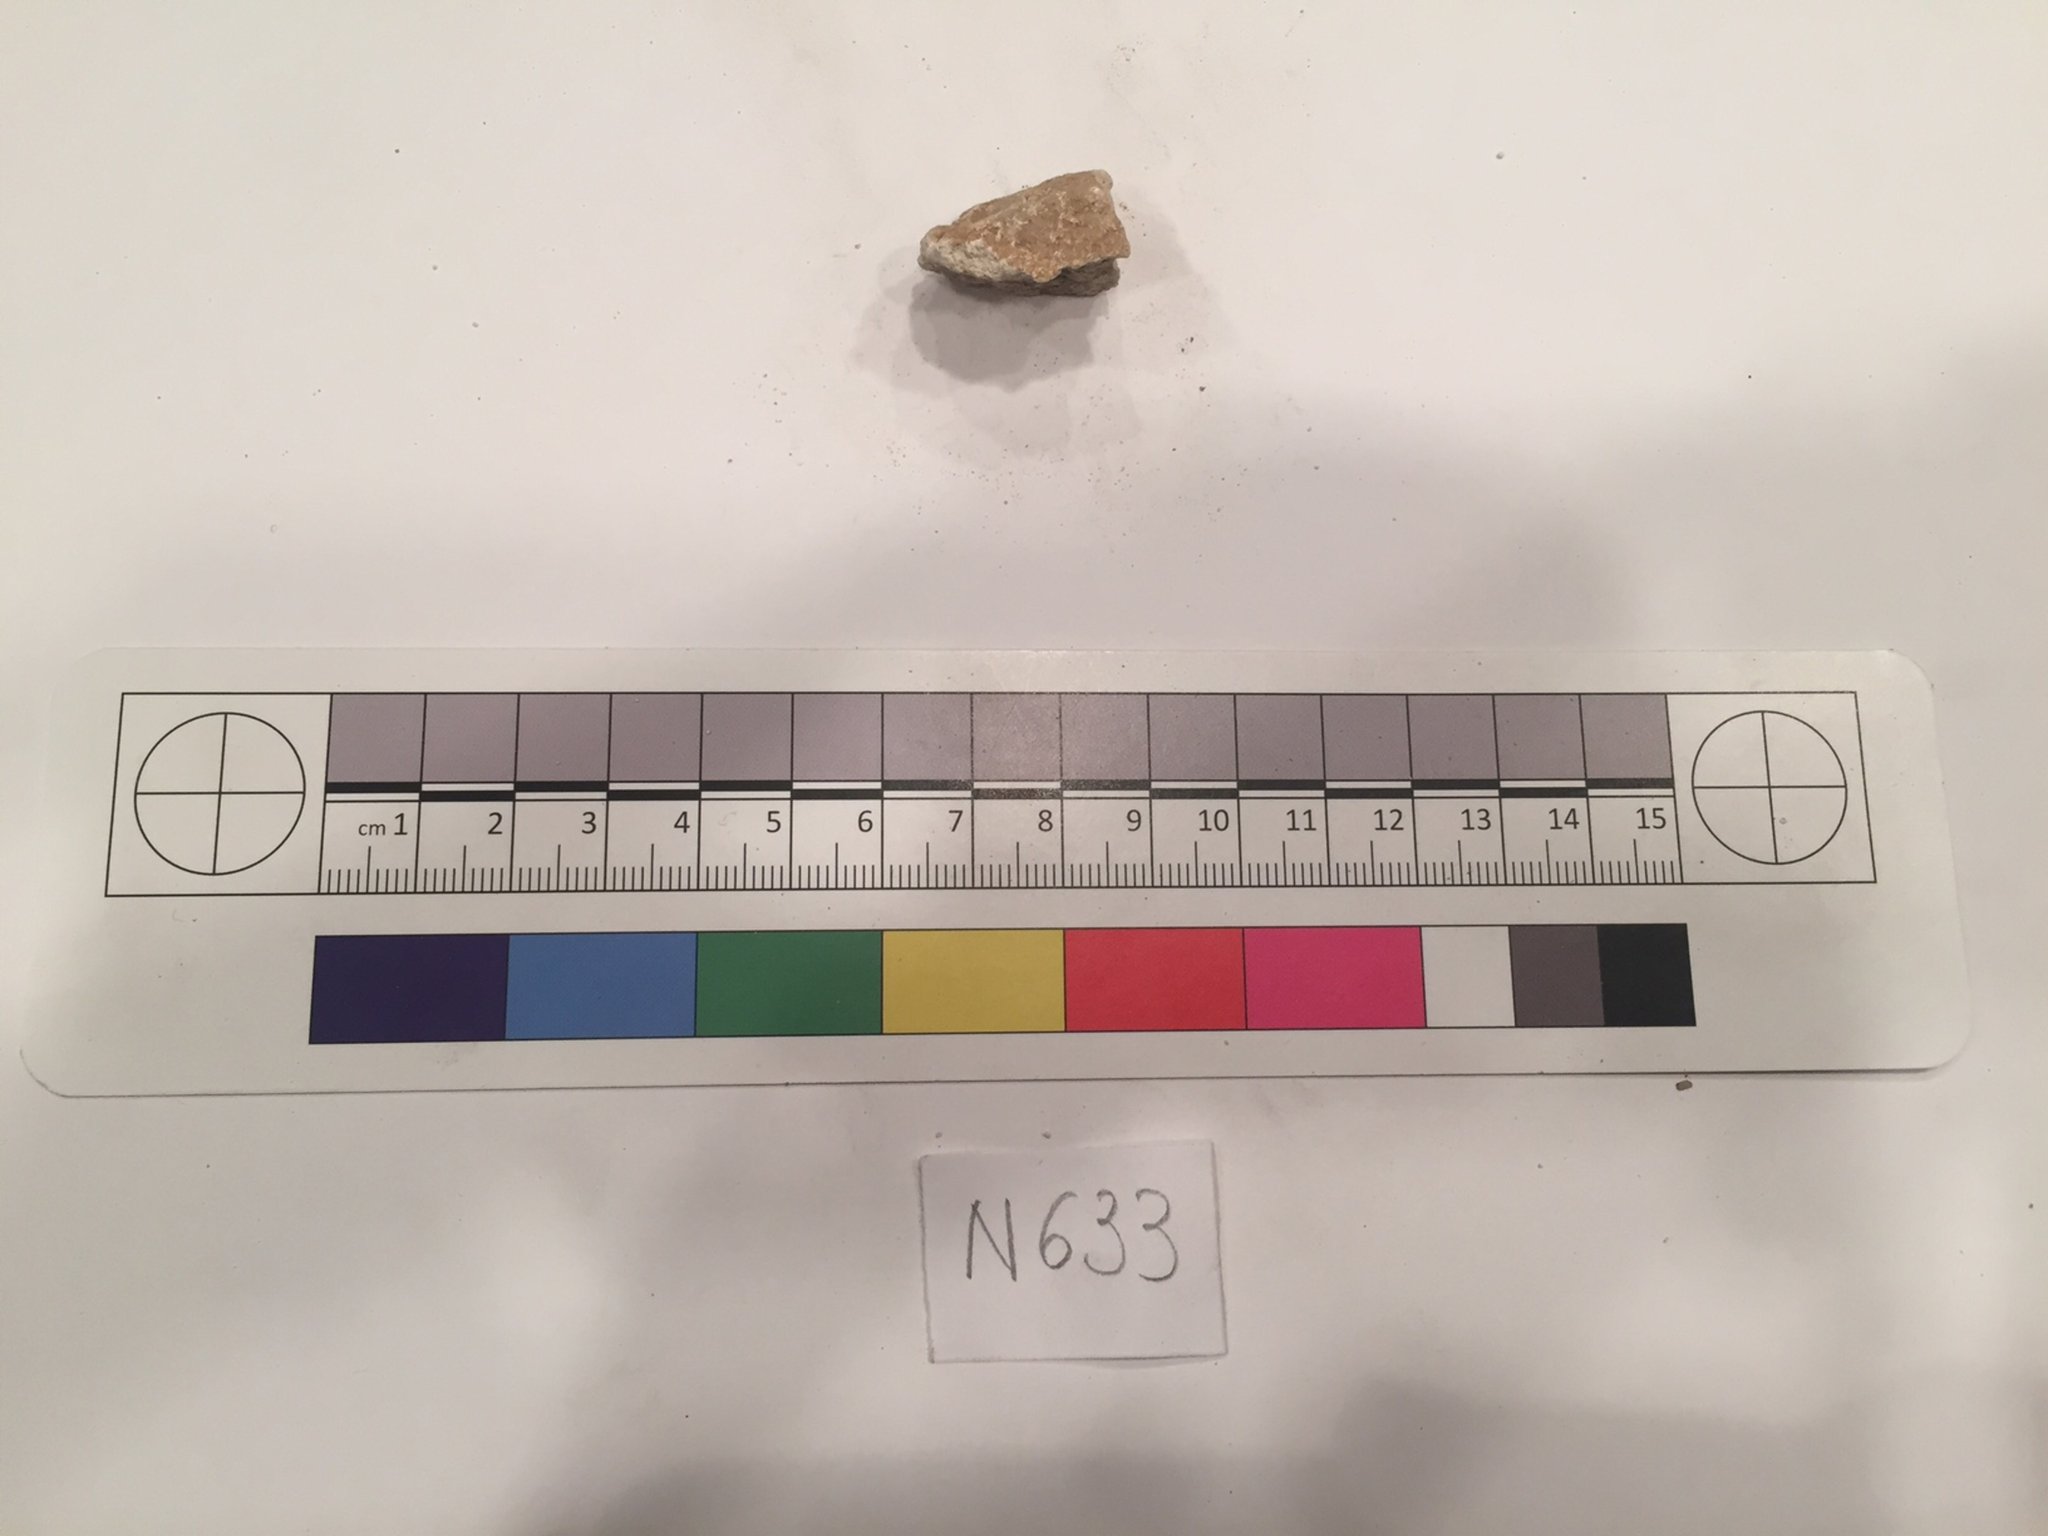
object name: fragment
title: Stucco Fragment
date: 701-1200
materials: plaster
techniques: carving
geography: iran